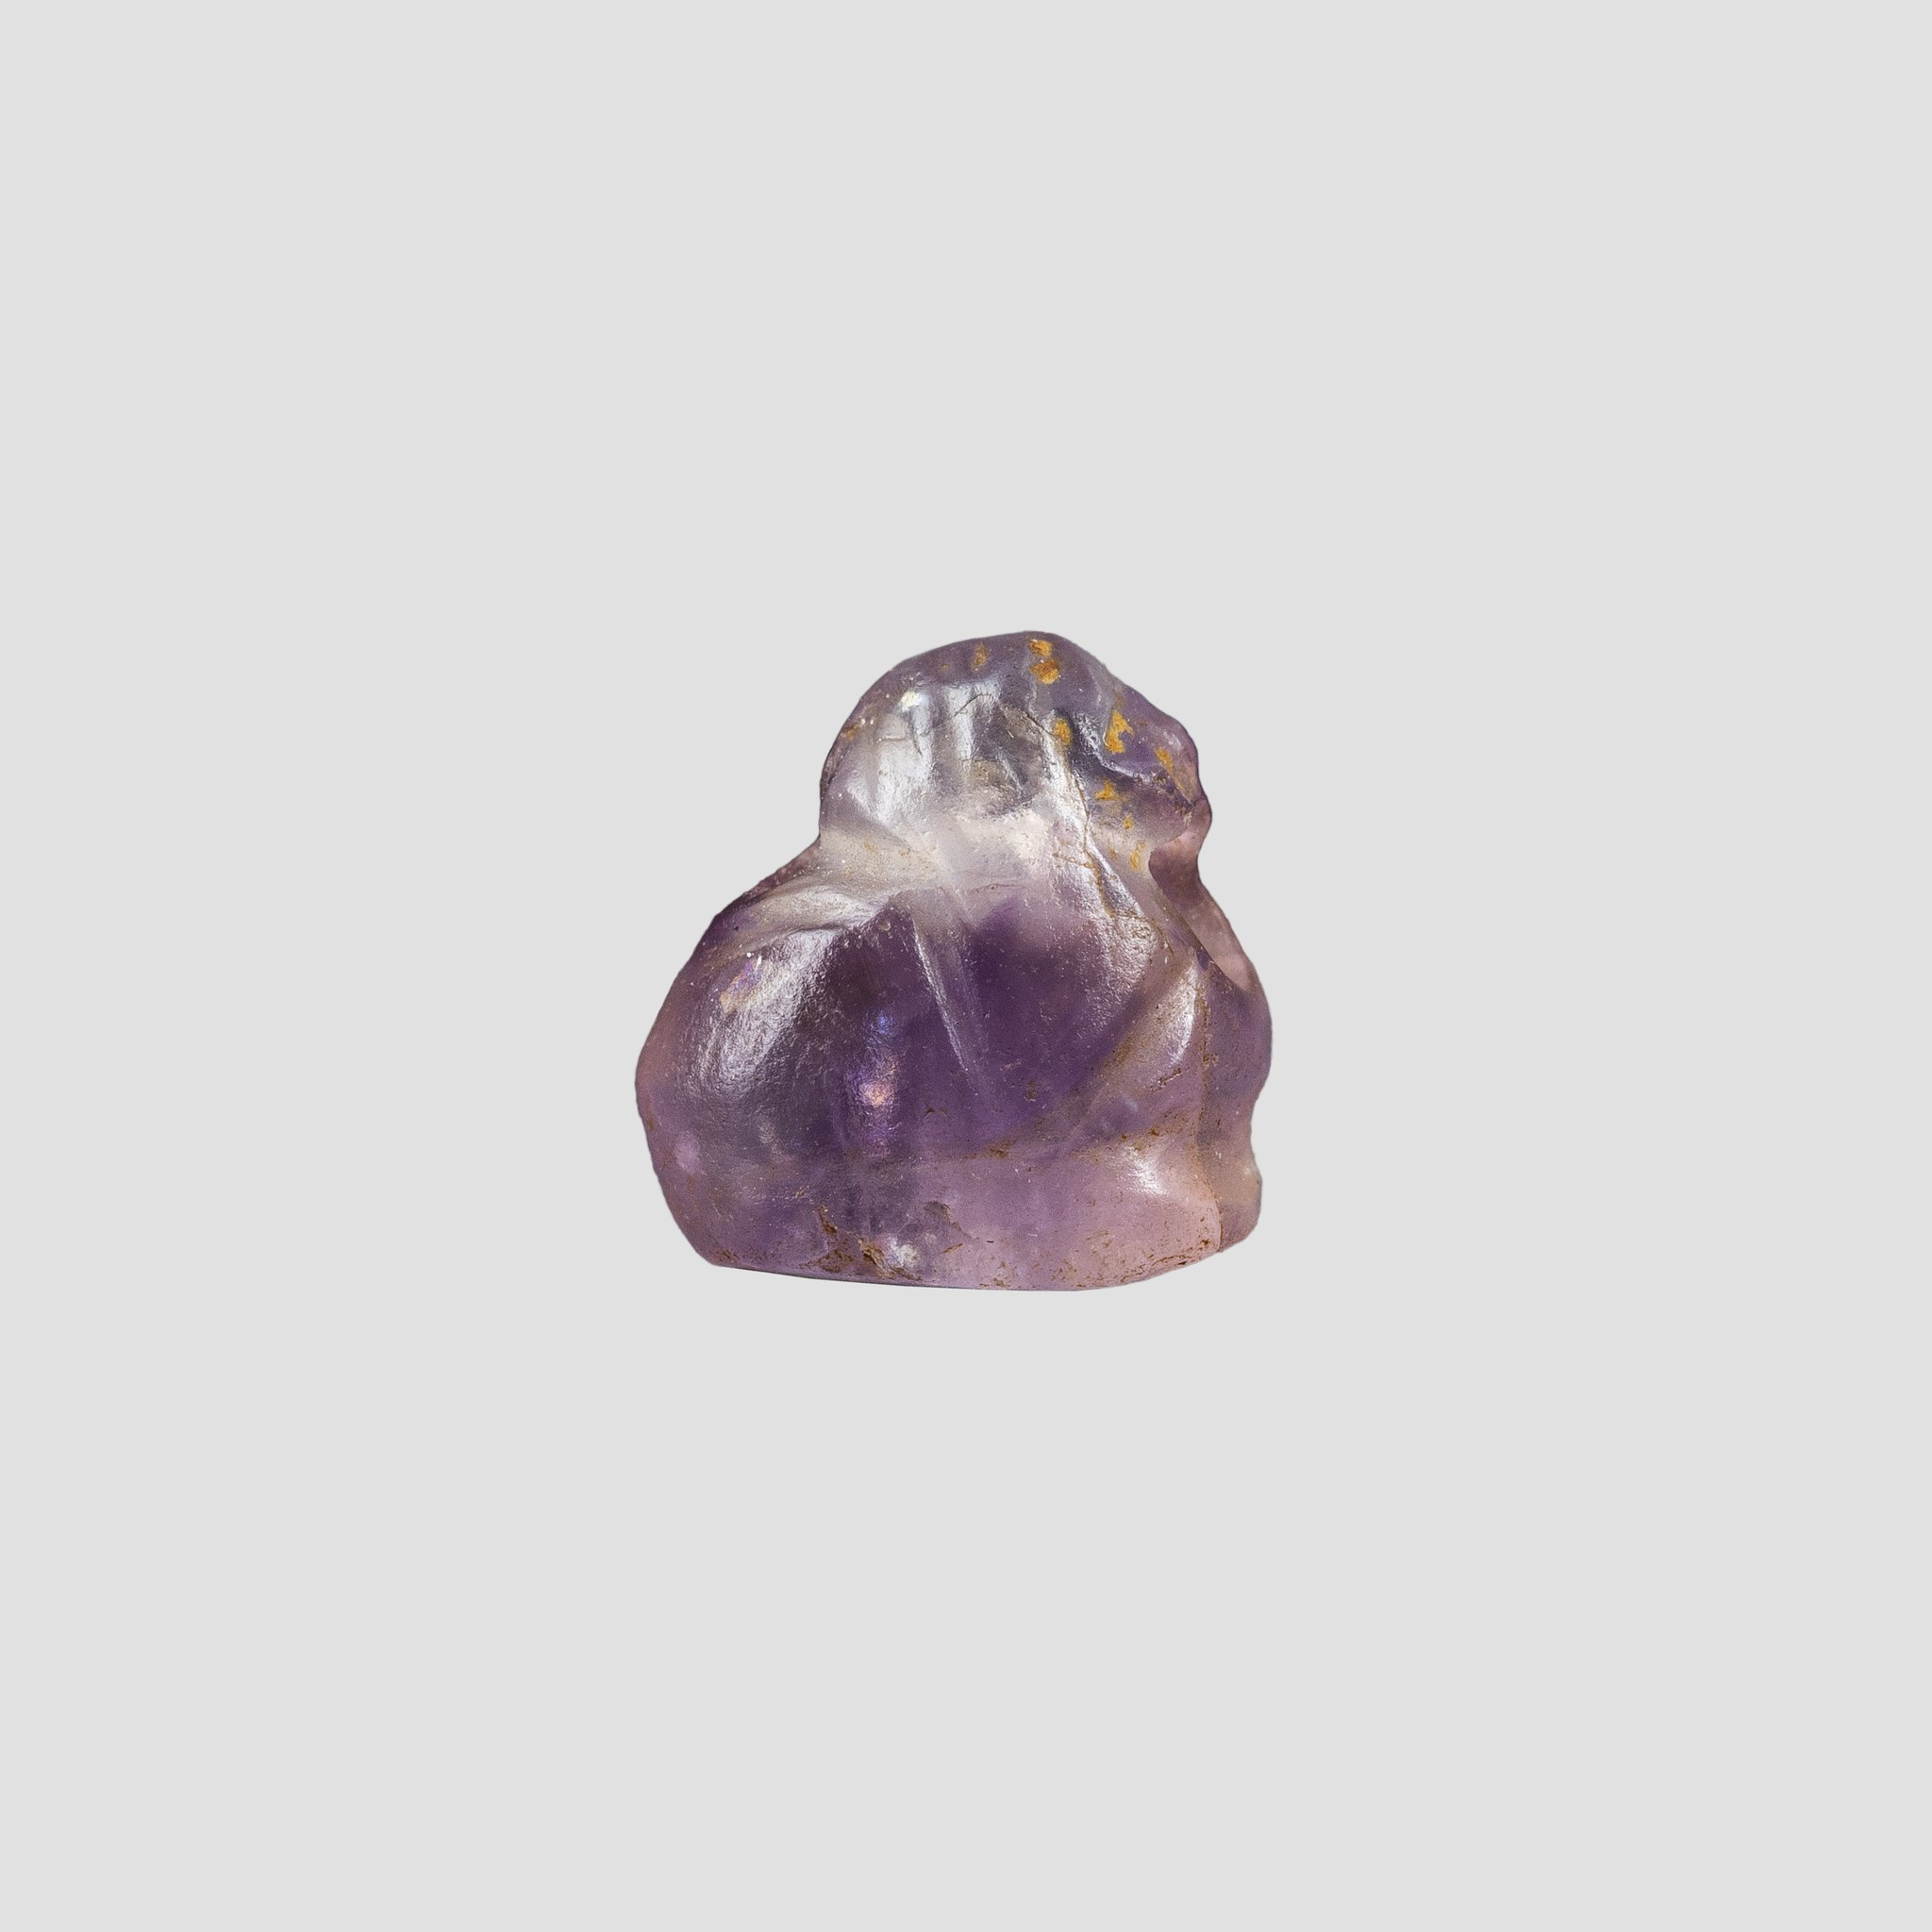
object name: human headed amulet bird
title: Human headed amulet (bird?)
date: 1981-1550 BCE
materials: gemstone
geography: egypt